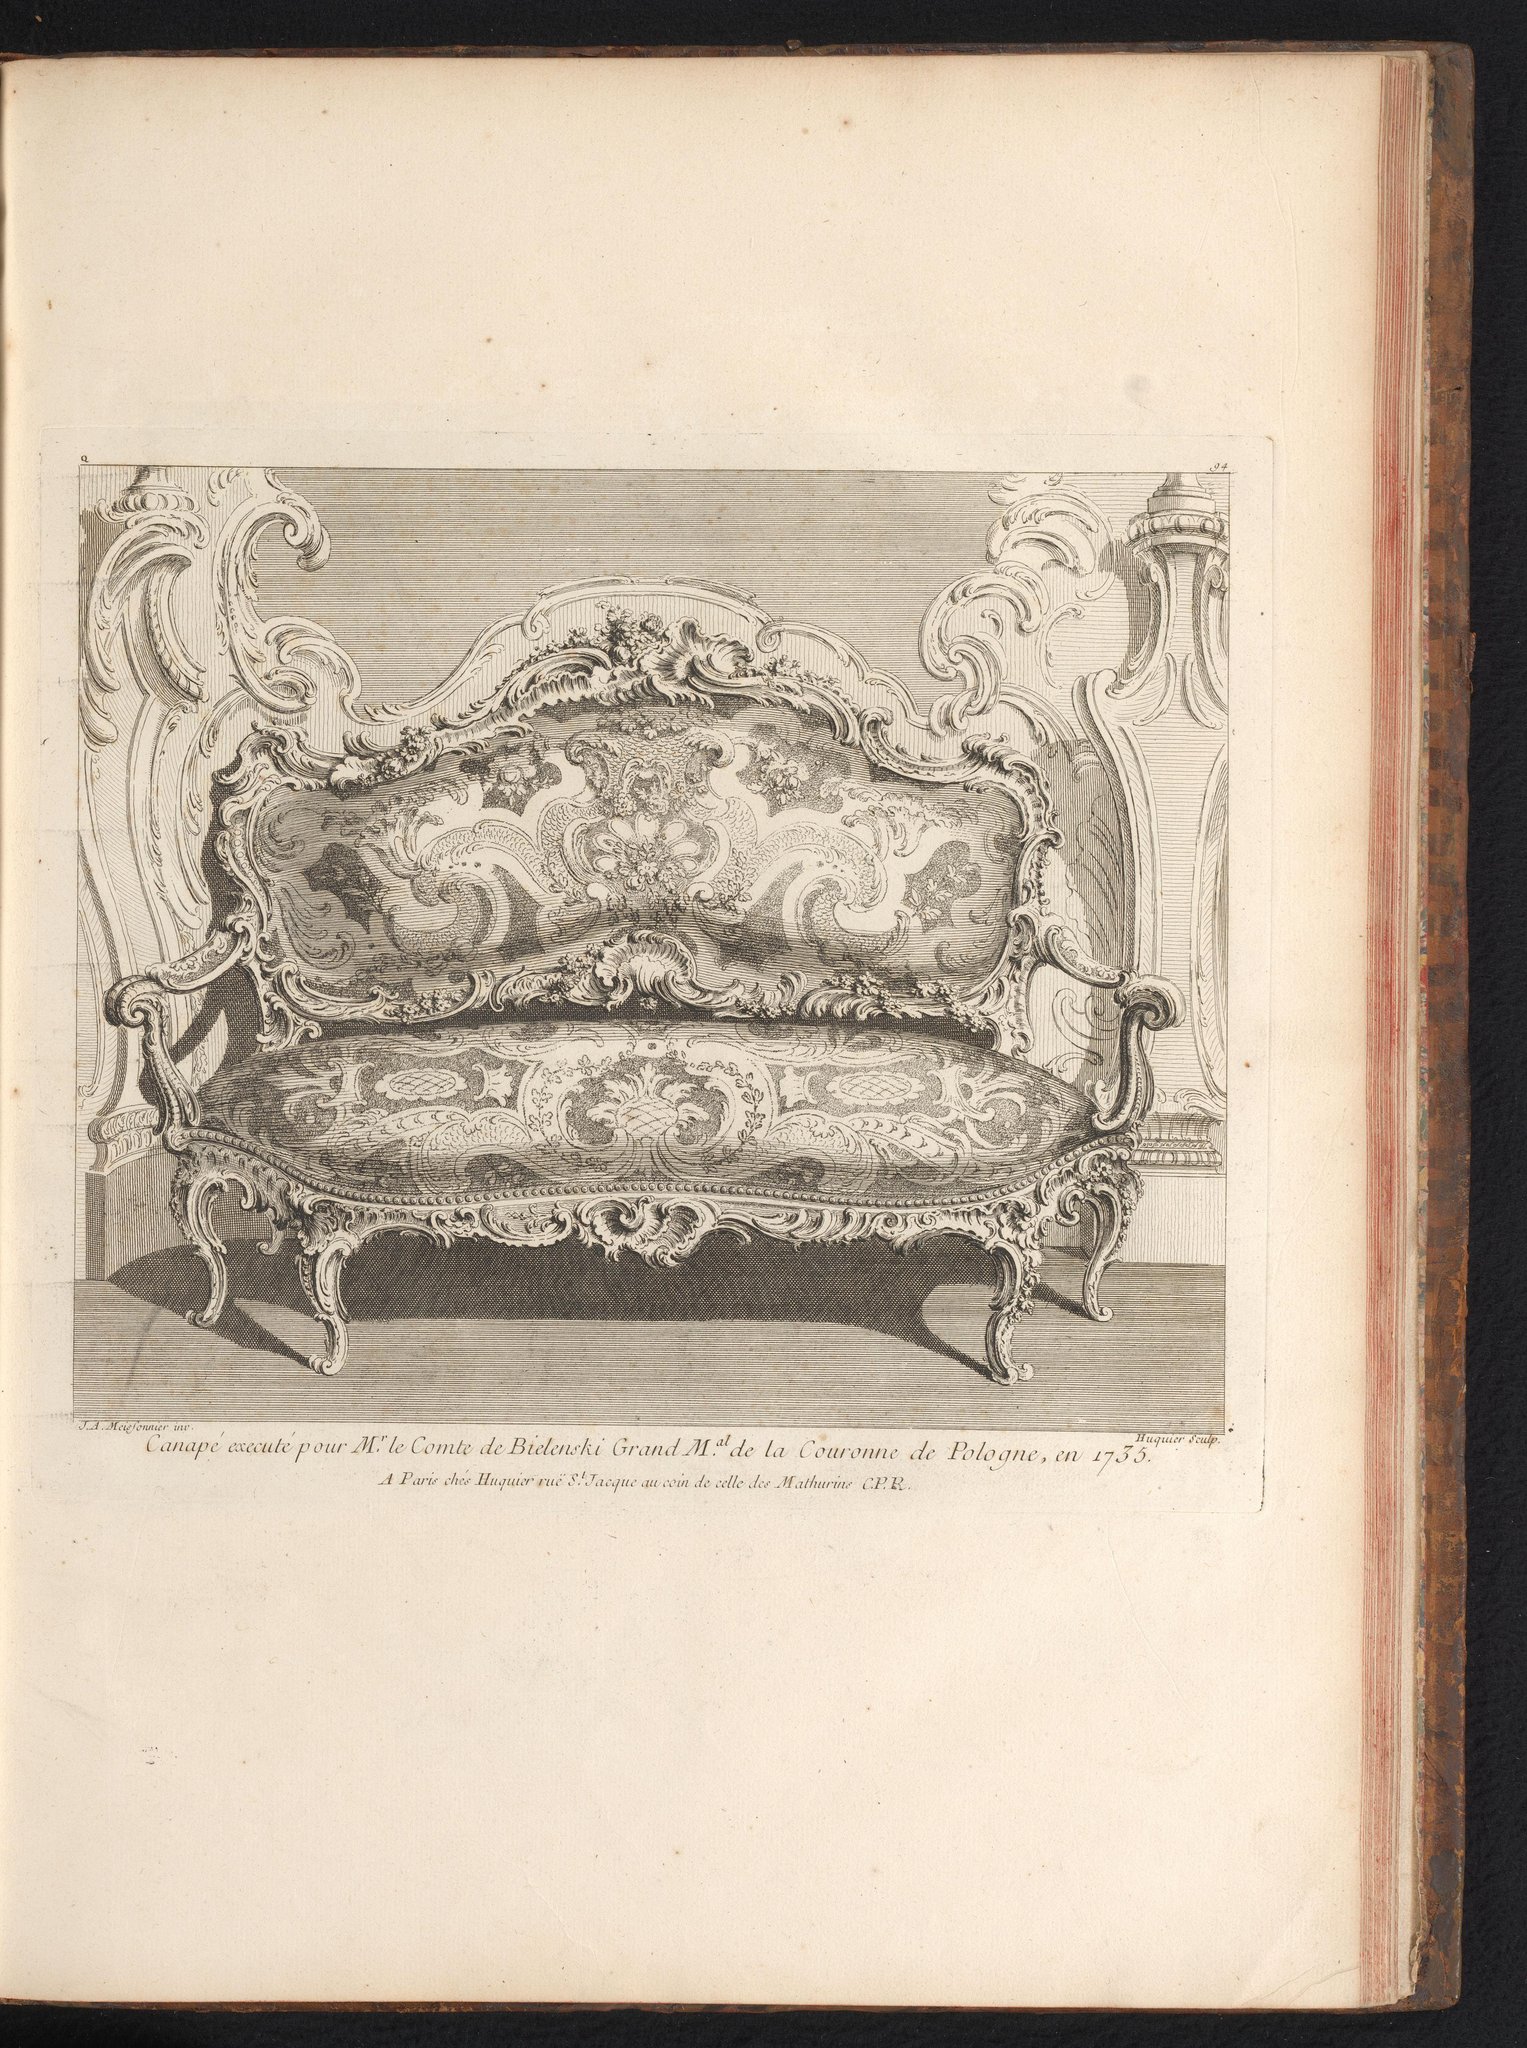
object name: album leaf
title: Canapé executé pour m.r le comte de Bielenski grand m.al de la couronne de Pologne, en 1735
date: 1738-1749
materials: paper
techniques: etching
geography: paris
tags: work of applied art, couch, sofa, settee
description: Deze prent maakt deel uit van een album.